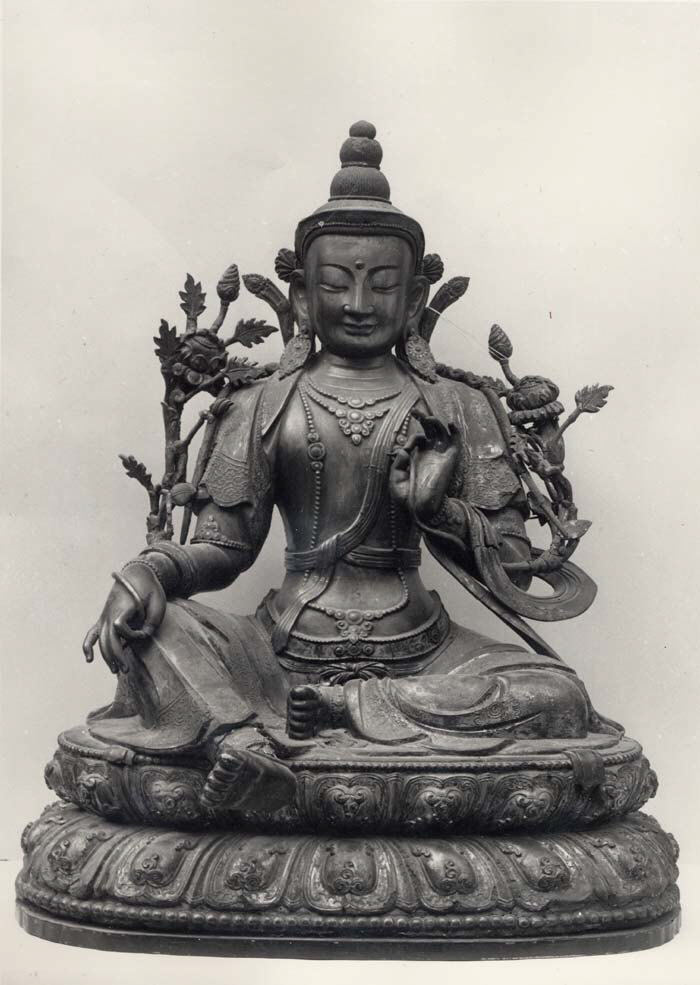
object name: figure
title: Figure on Lotus Throne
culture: chinese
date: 1601-1800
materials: wood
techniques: lacquer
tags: buddhism,deities